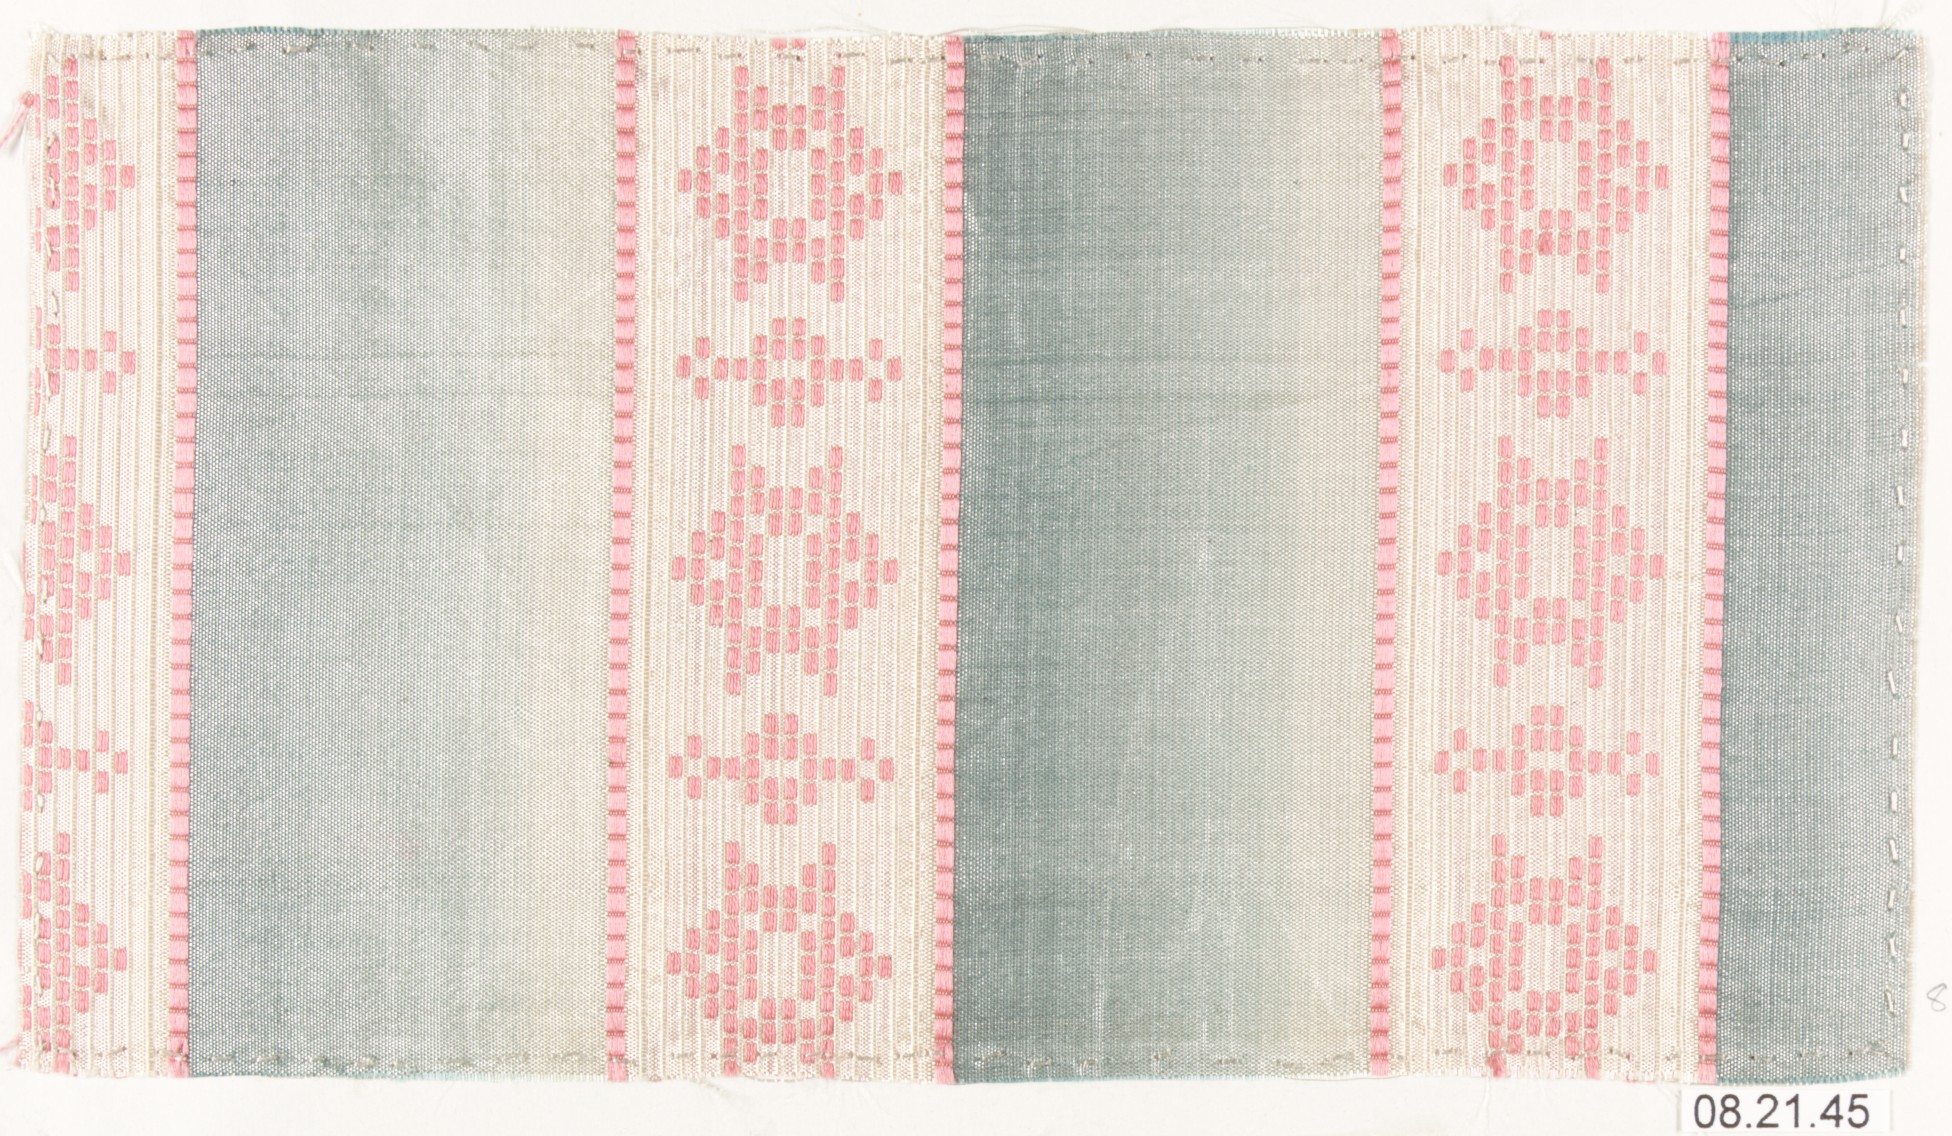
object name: textile sample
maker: Anonymous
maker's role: designer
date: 1900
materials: silk